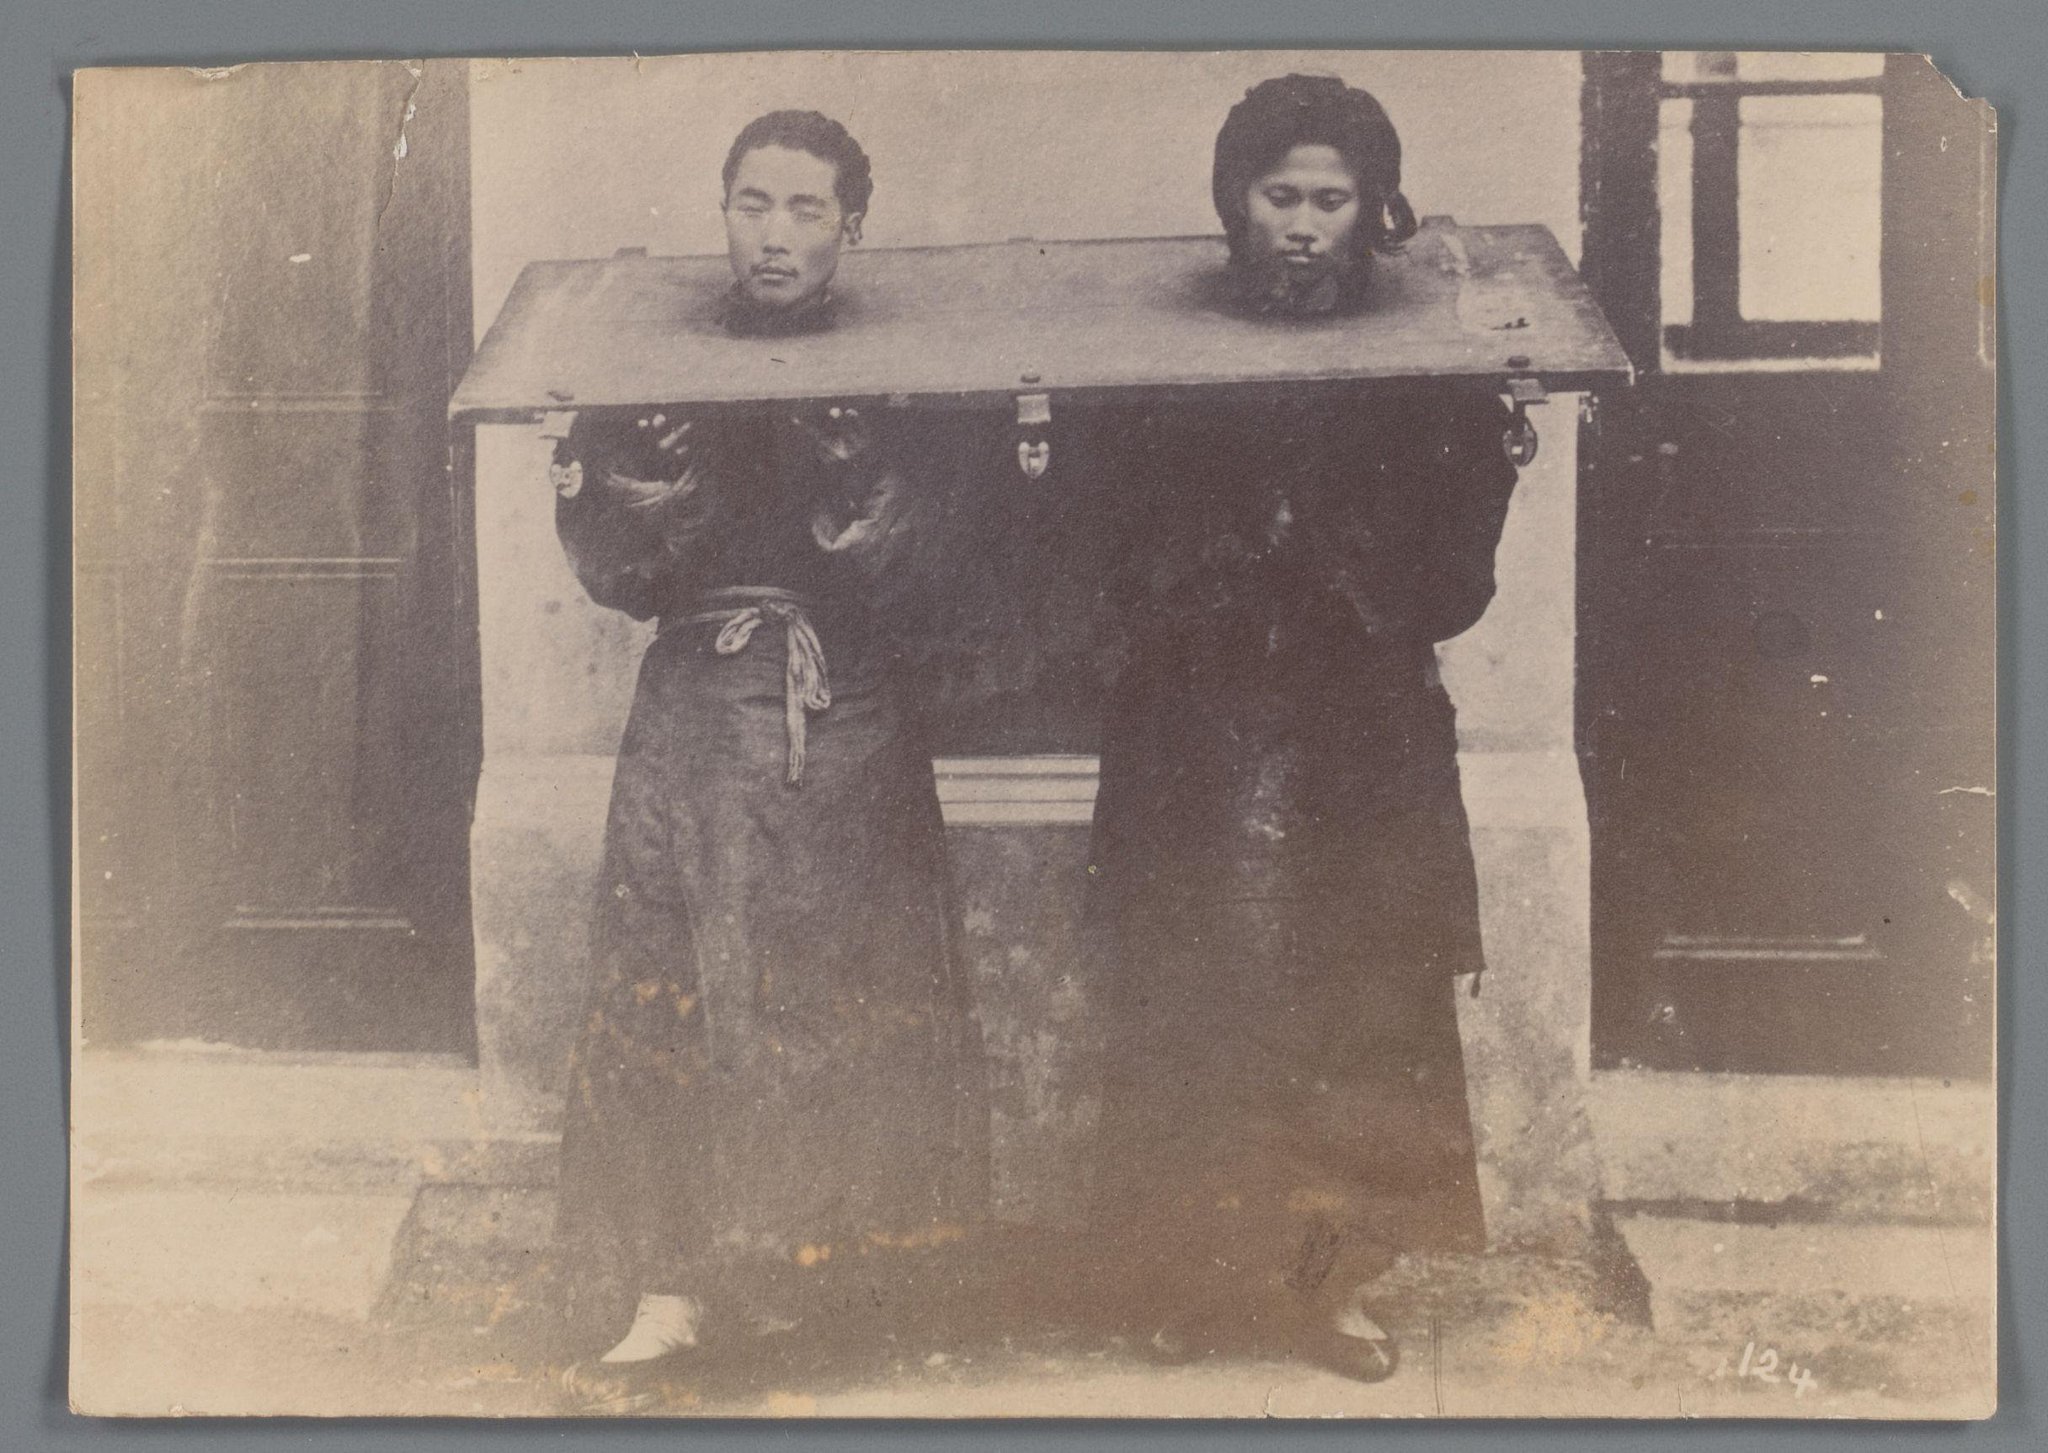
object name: photograph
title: Twee mensen in een schandbord, China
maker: Anonymous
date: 1880-1900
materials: paper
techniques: gelatin silver print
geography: china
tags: in the pillory, in the stocks, china